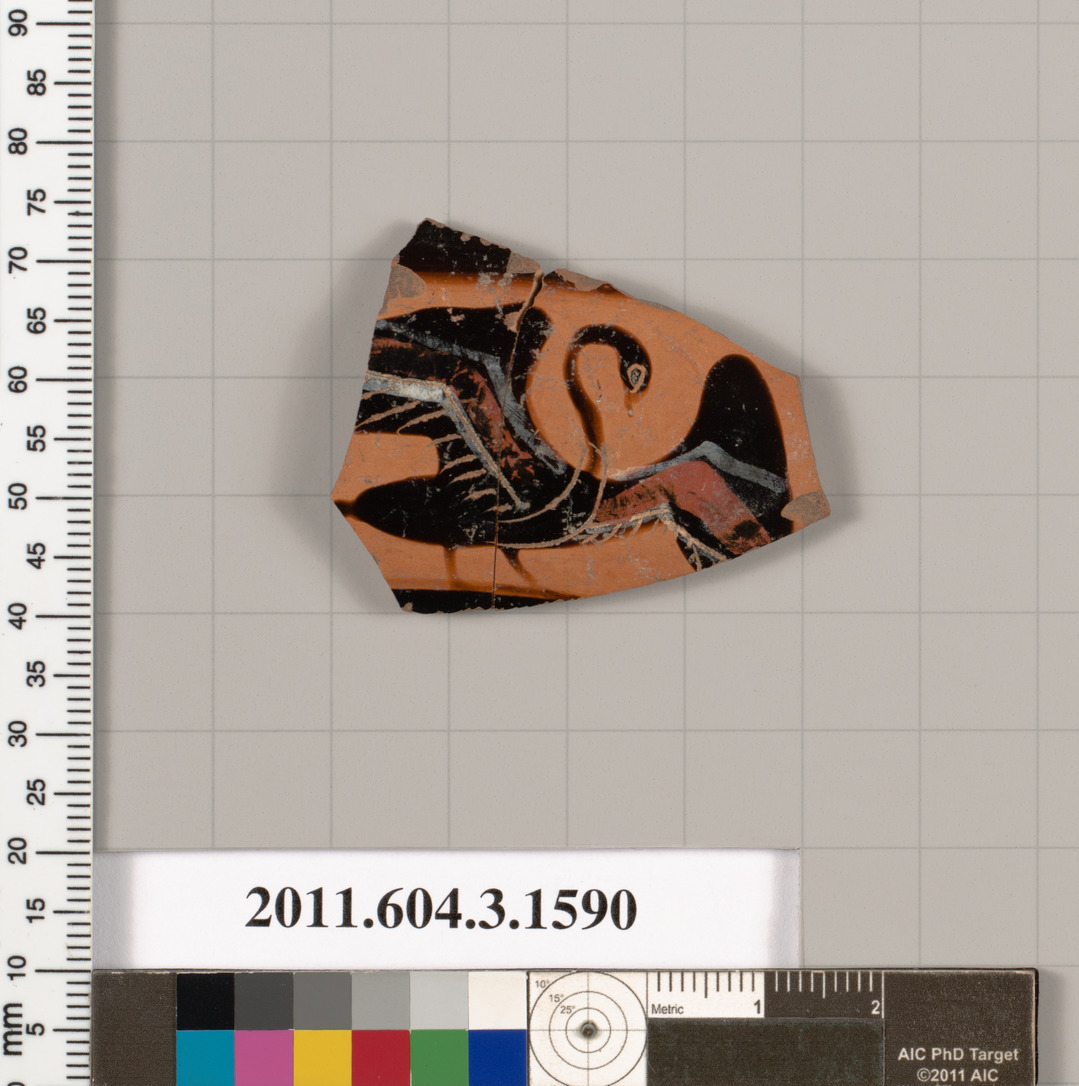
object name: kylix fragment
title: Terracotta fragment of a kylix: Band cup (drinking cup)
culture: greek, attic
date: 550-526 BCE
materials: terracotta